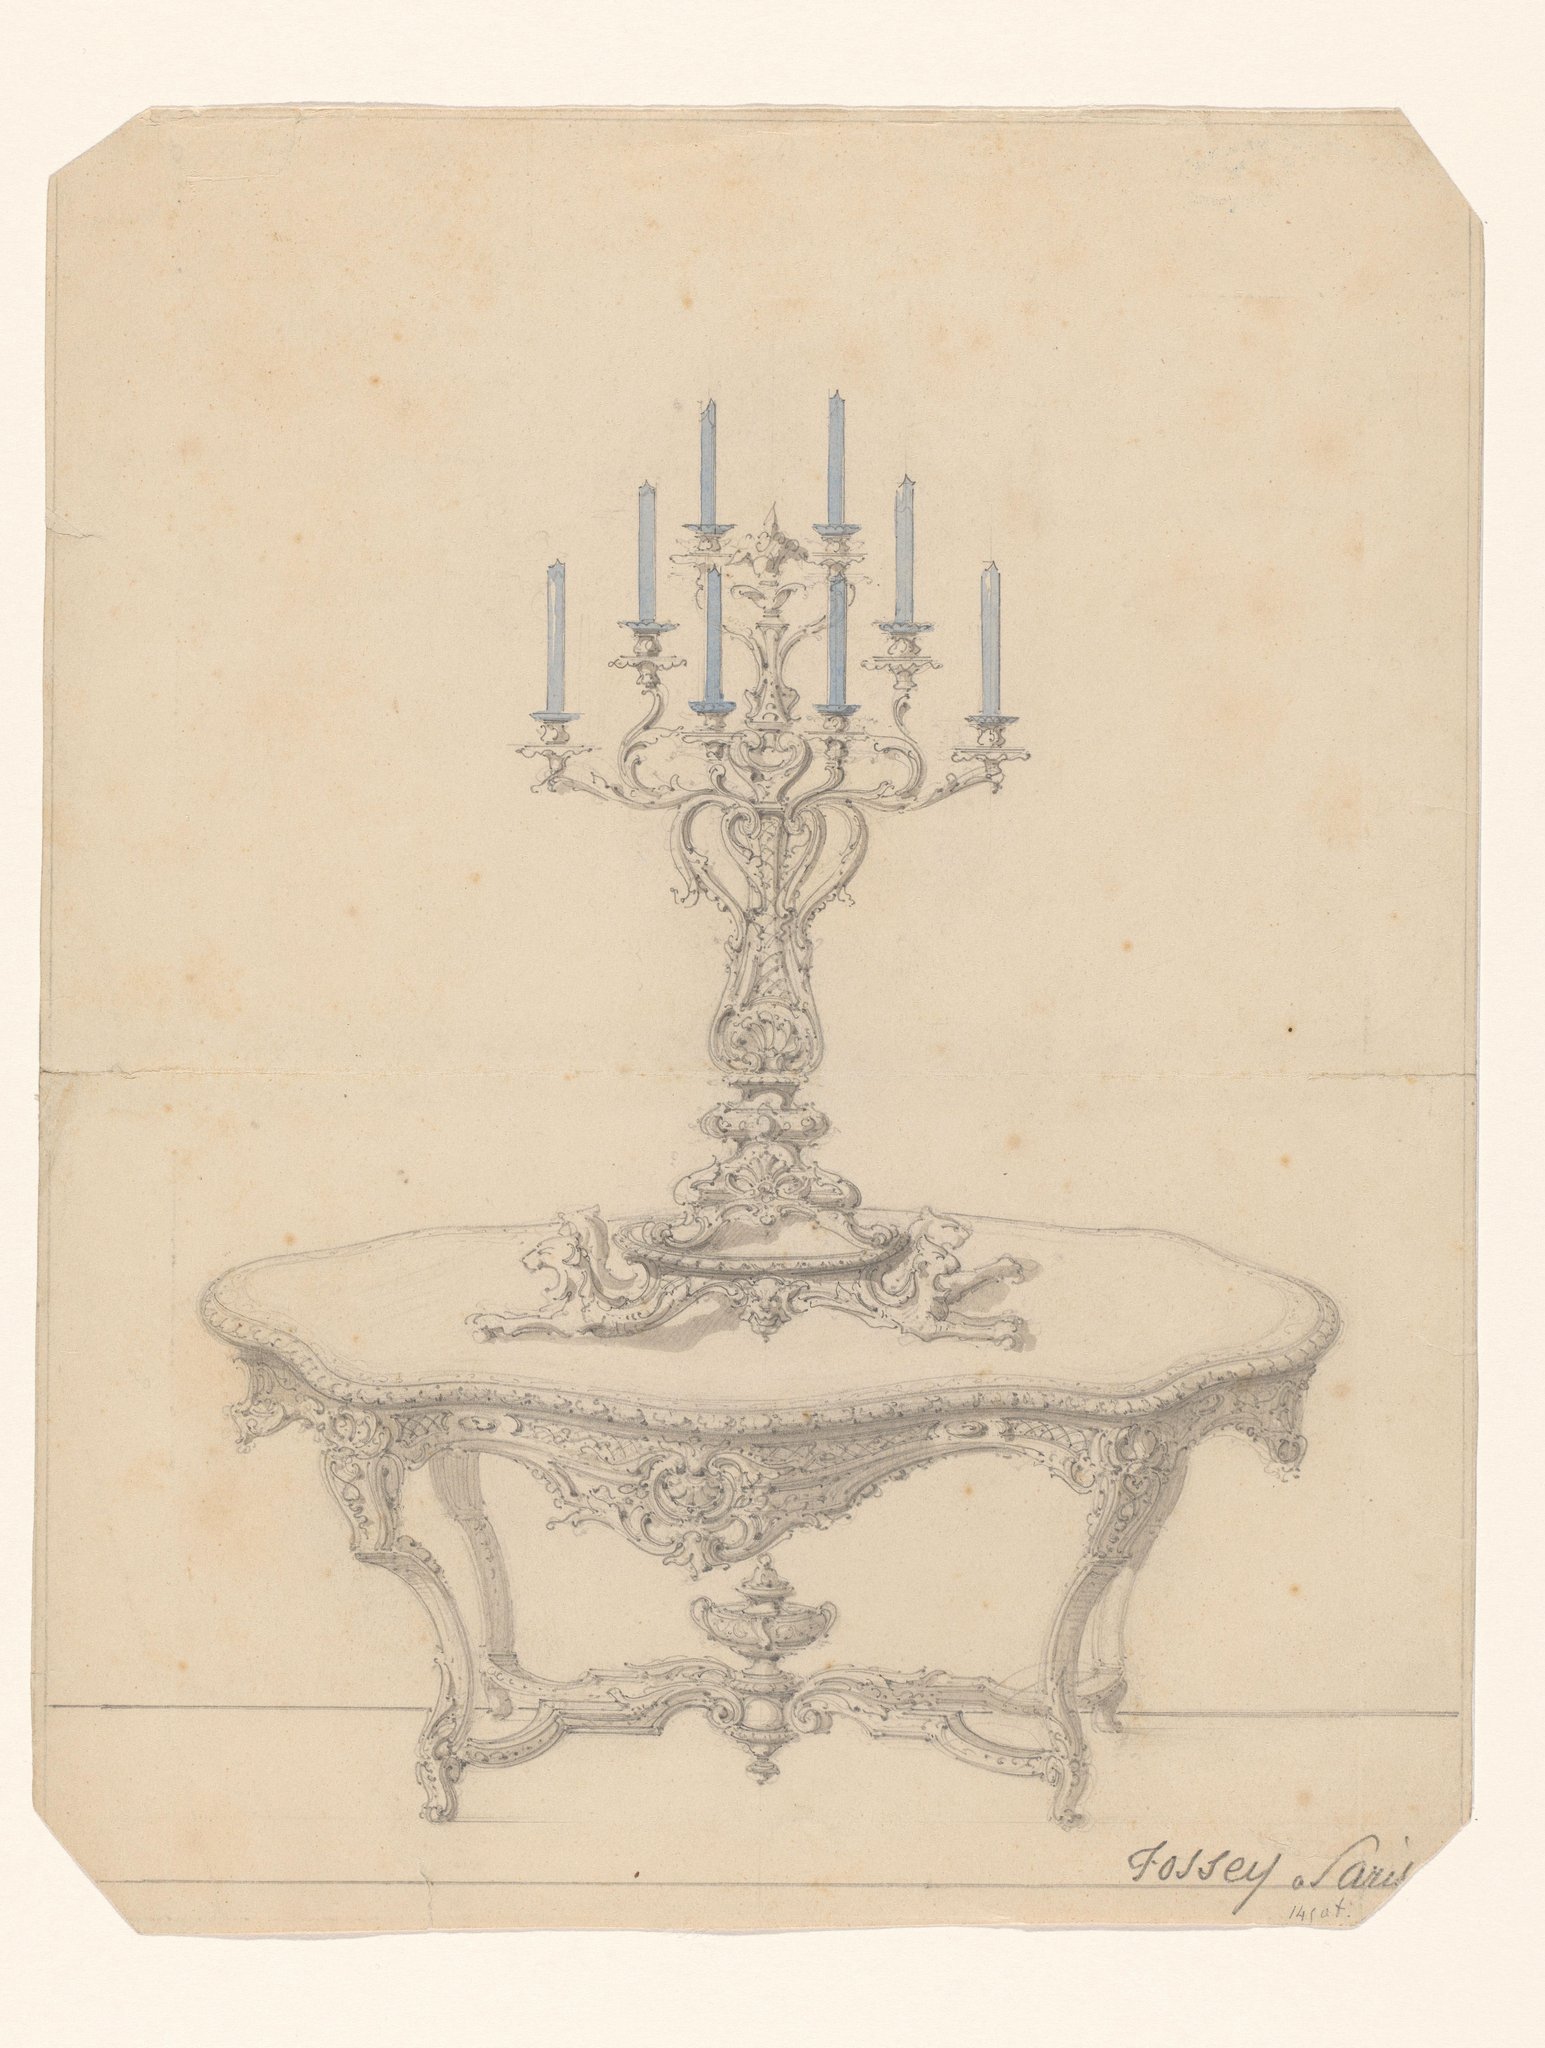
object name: design drawing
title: Tafel in neo-rococo-stijl met daarop een kandelaber met acht kaarsen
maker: jules fossey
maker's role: draughtsman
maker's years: 1806-1858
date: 1850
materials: graphite, paper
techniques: brush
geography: france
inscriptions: inscription: ‘1450 f’, signature: ‘Fossey a Paris’